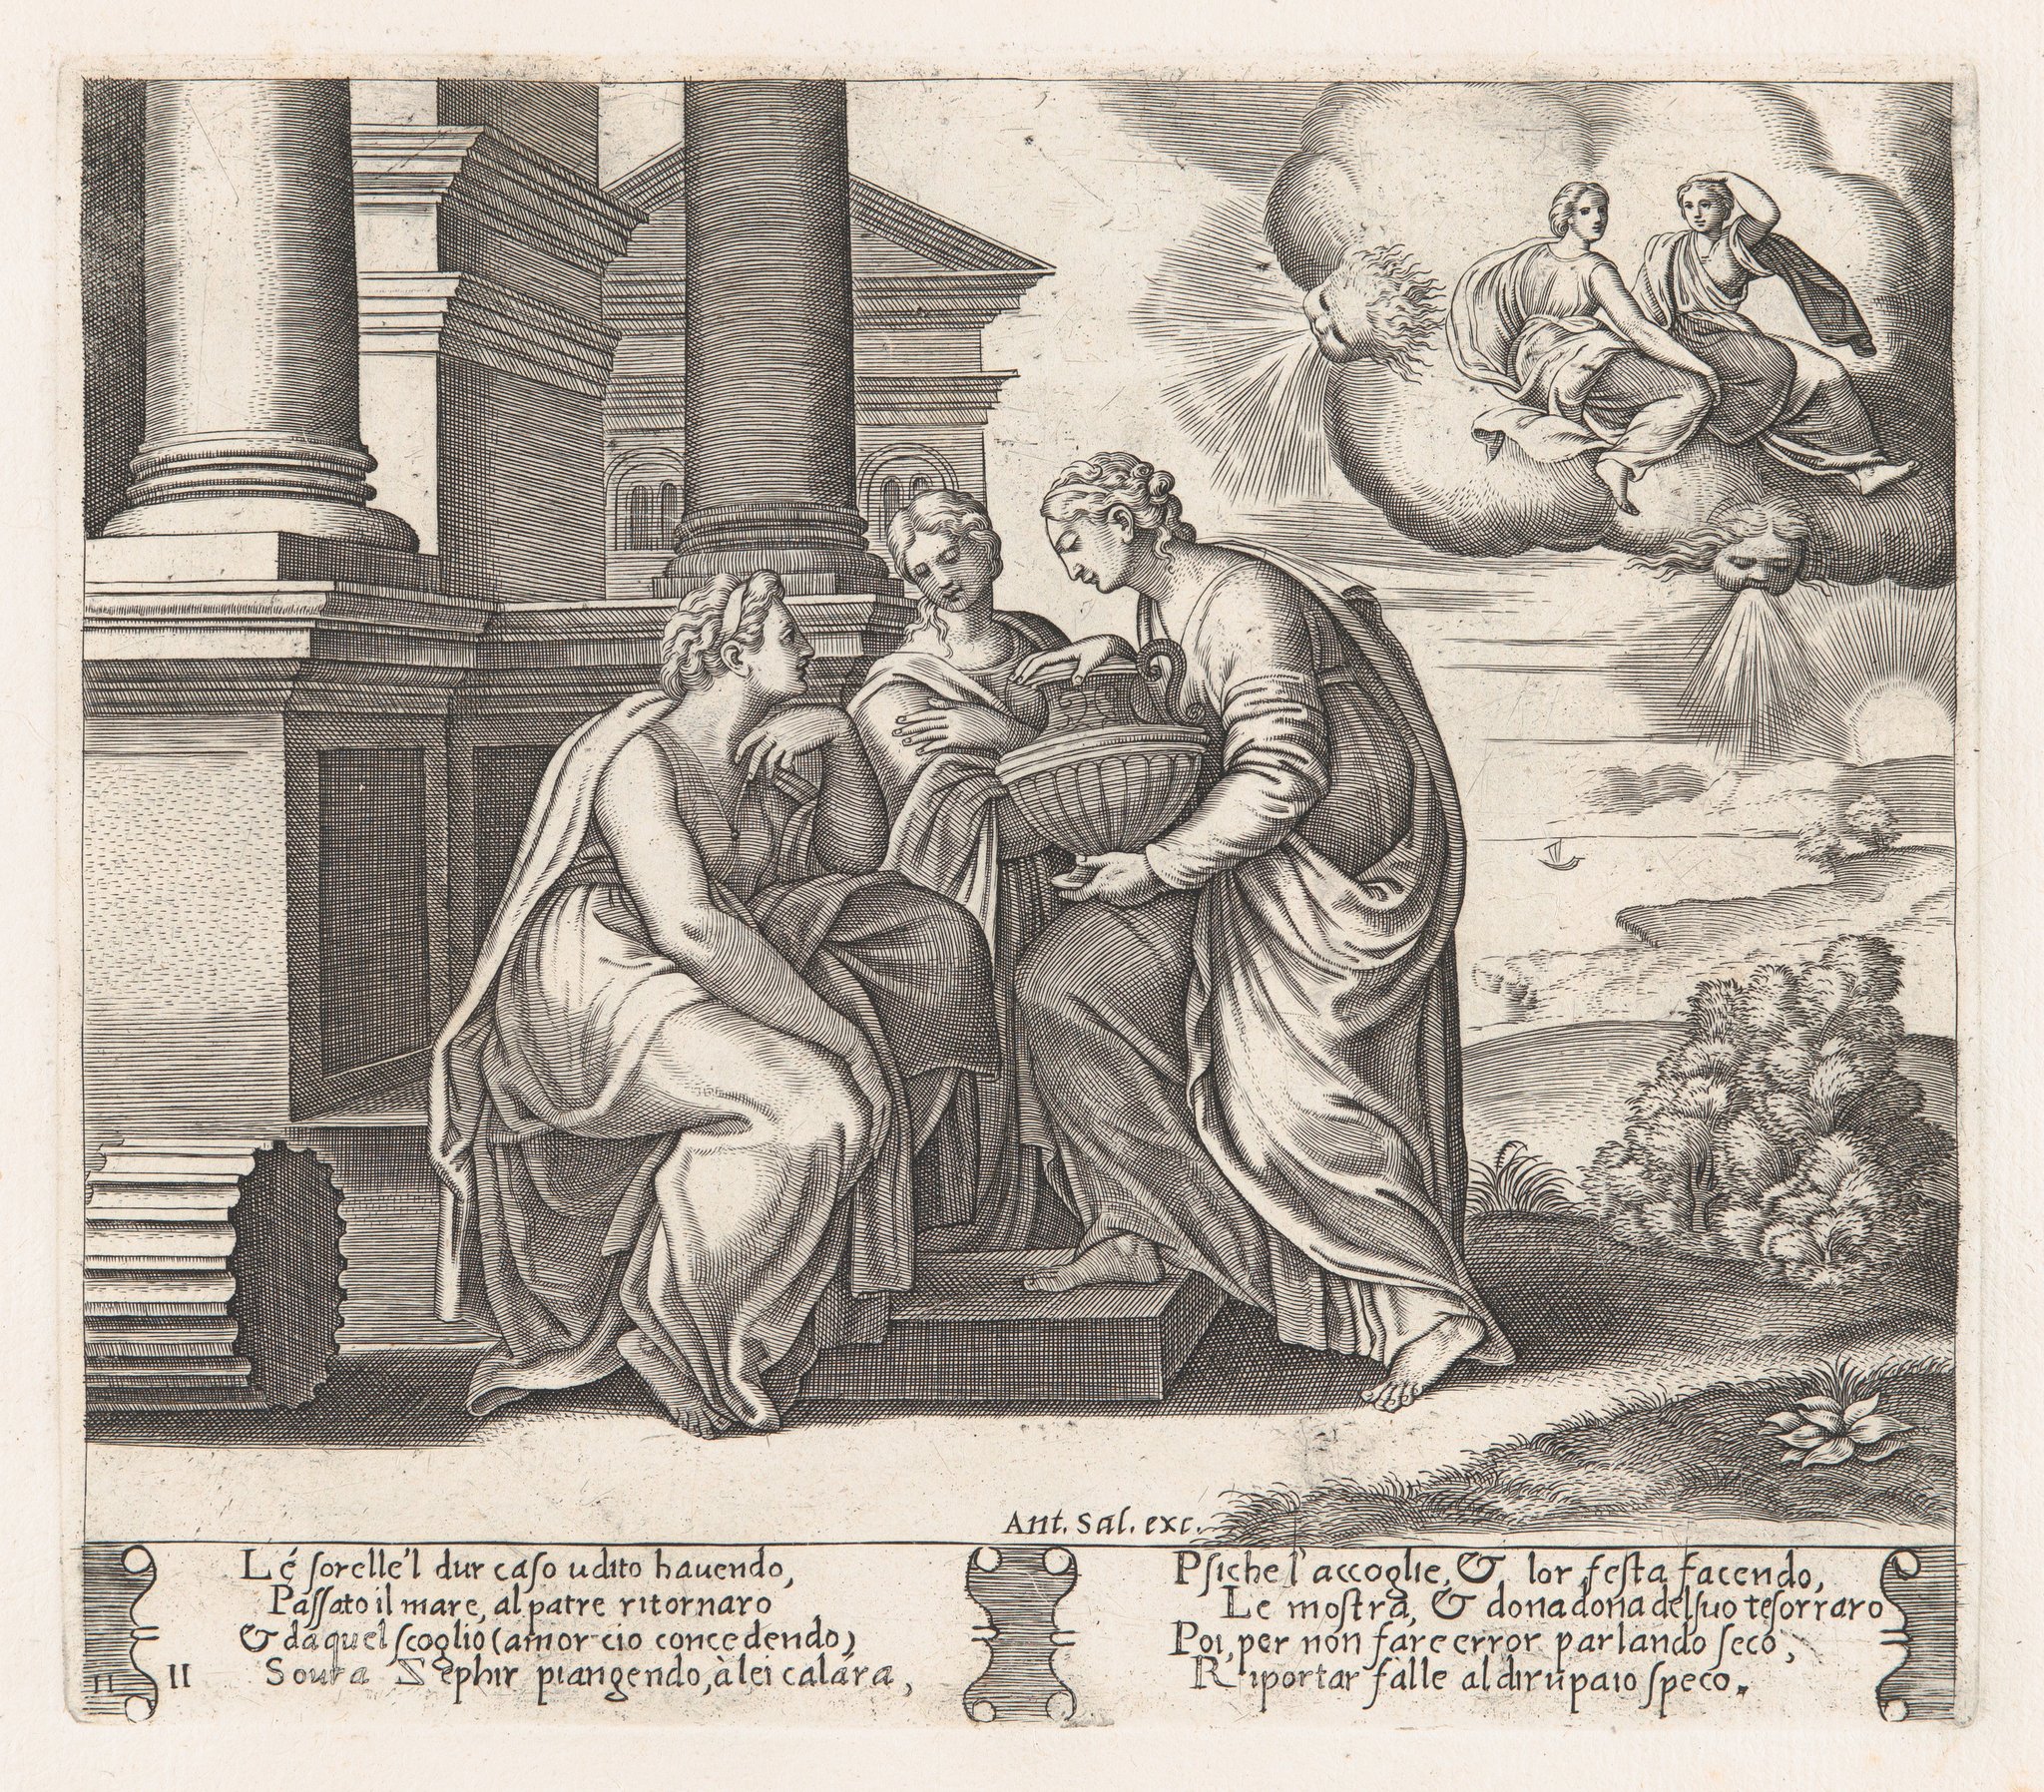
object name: print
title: Plate 11: Psyche offering presents to her sisters who also appear on the clouds at upper right, from "The Story of Cupid and Psyche as told by Apuleius"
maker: master of the die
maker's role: artist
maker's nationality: italian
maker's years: 1525-1560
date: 1530-1560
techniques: engraving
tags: women,psyche